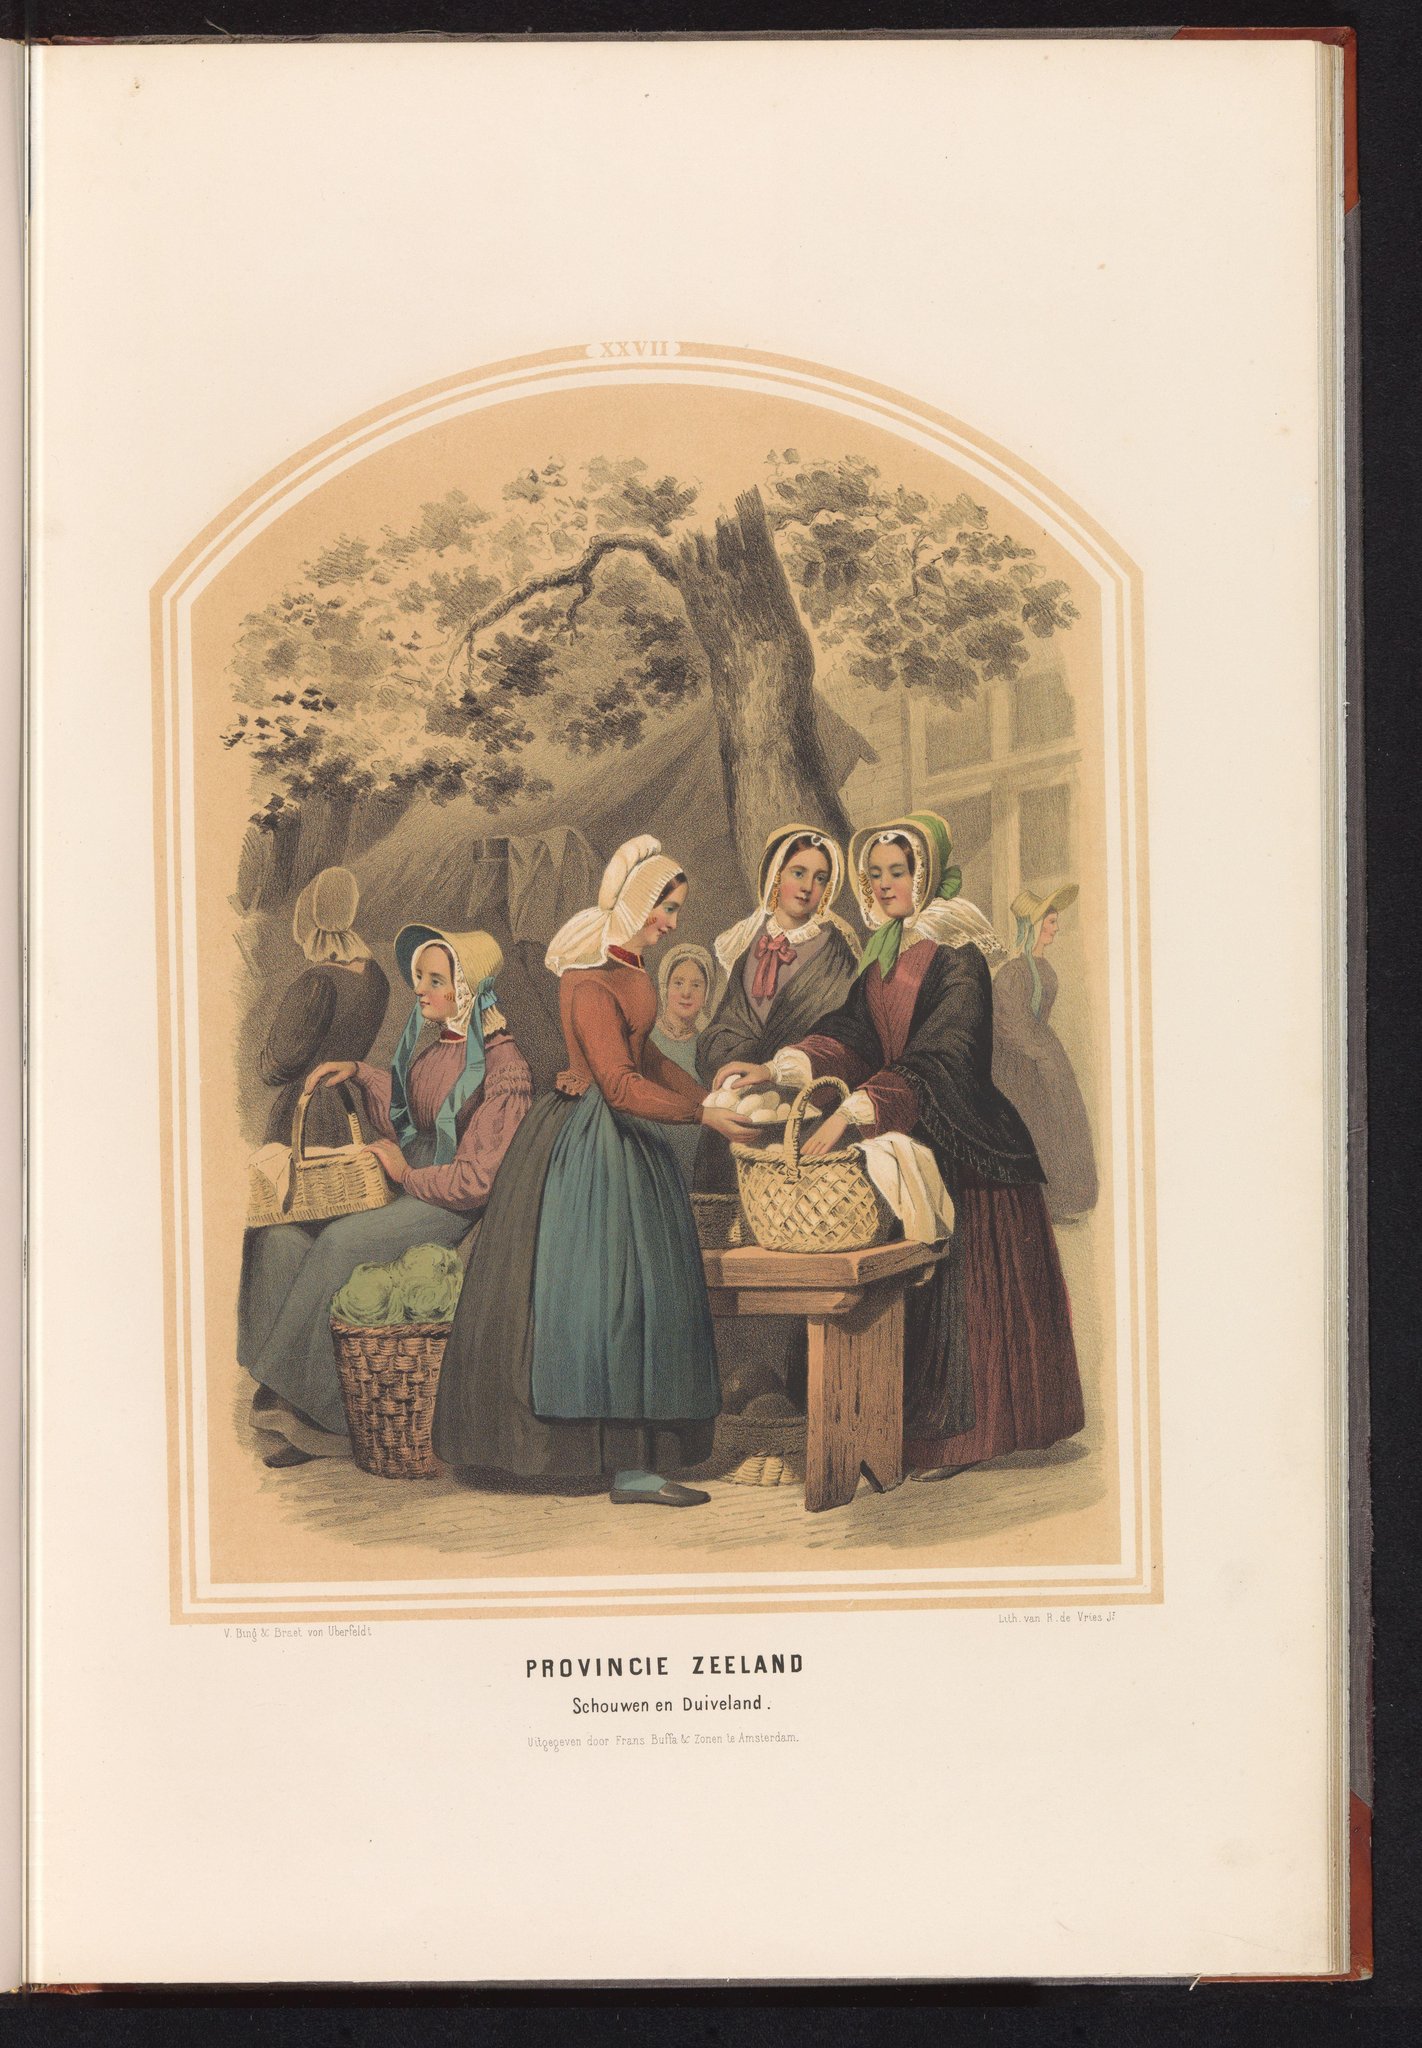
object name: print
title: Provincie Zeeland. Schouwen en Duiveland / XXVII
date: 1857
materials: paper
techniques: hand coloring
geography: netherlands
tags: folk costume, regional costume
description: Klederdracht van de eilanden Schouwen en Duiveland in Zeeland. Vrouwen op de markt. Illustratie in een boek uit 1857 met 56 platen van Nederlandse klederdrachten.